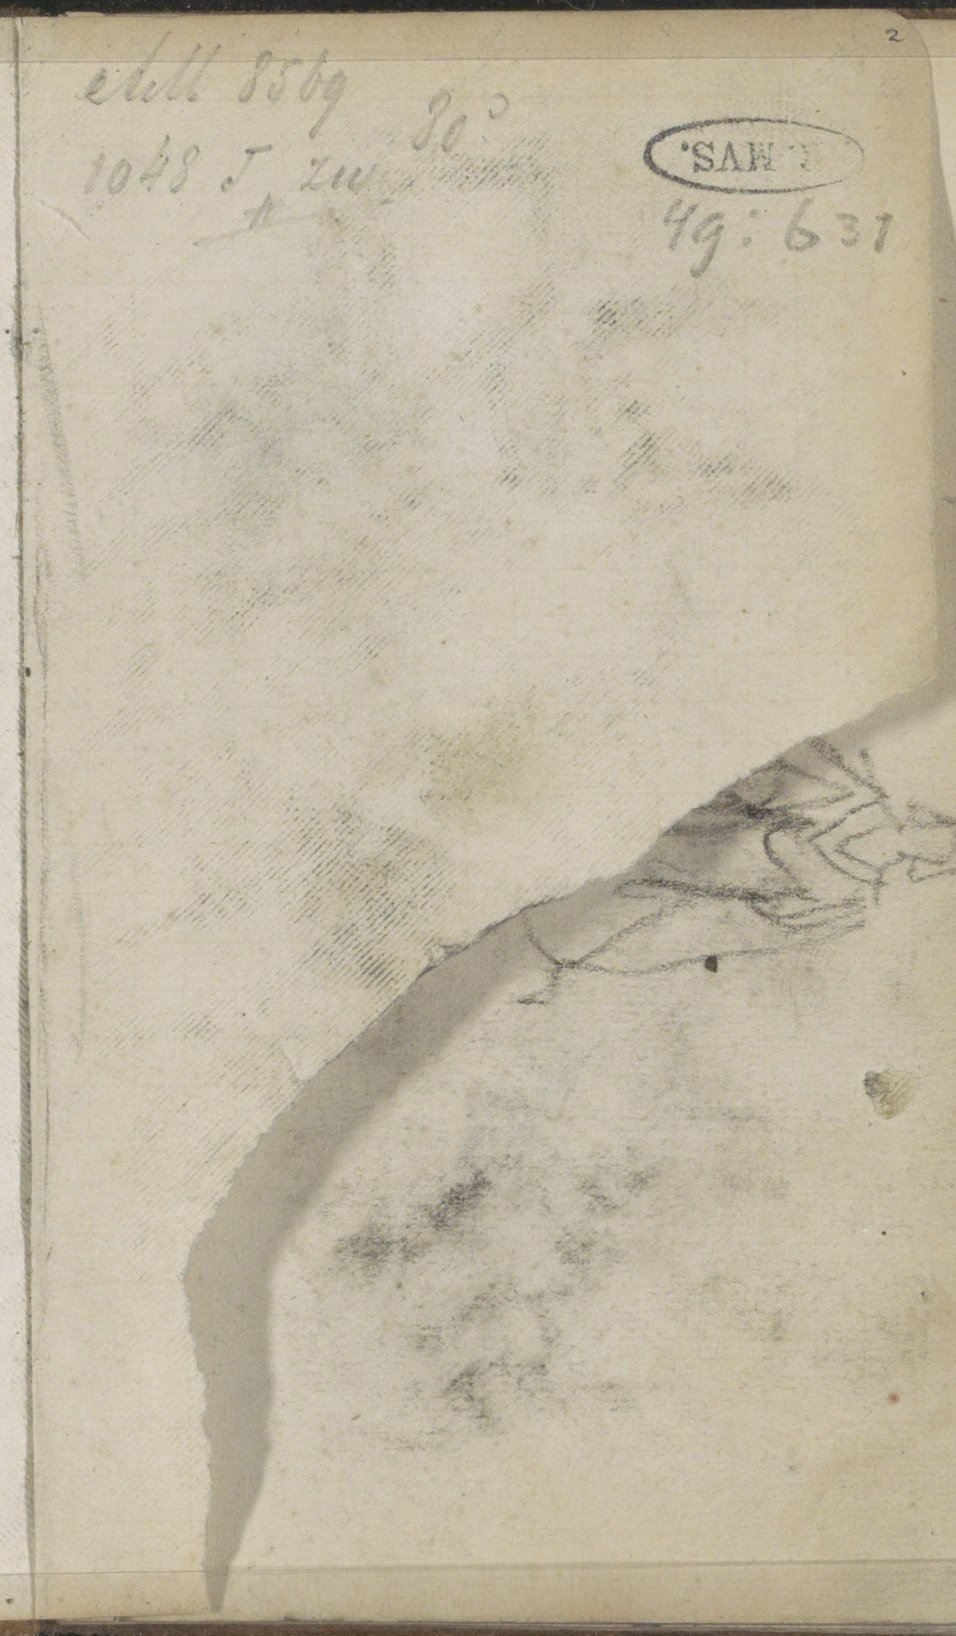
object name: sketchbook leaf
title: Blad met notities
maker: marius bauer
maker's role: draughtsman, print maker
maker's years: 1867-1932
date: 1879-1885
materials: paper, pencil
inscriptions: annotation: ‘AM 8569/ 30?/ 1048 J zw’, collector's mark: Lugt 2228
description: Pagina 2 uit een schetsboek met 58 bladen.